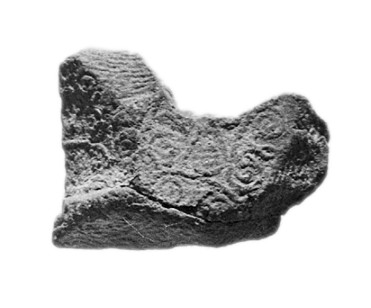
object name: sealing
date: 1981-1640 BCE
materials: mud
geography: egypt